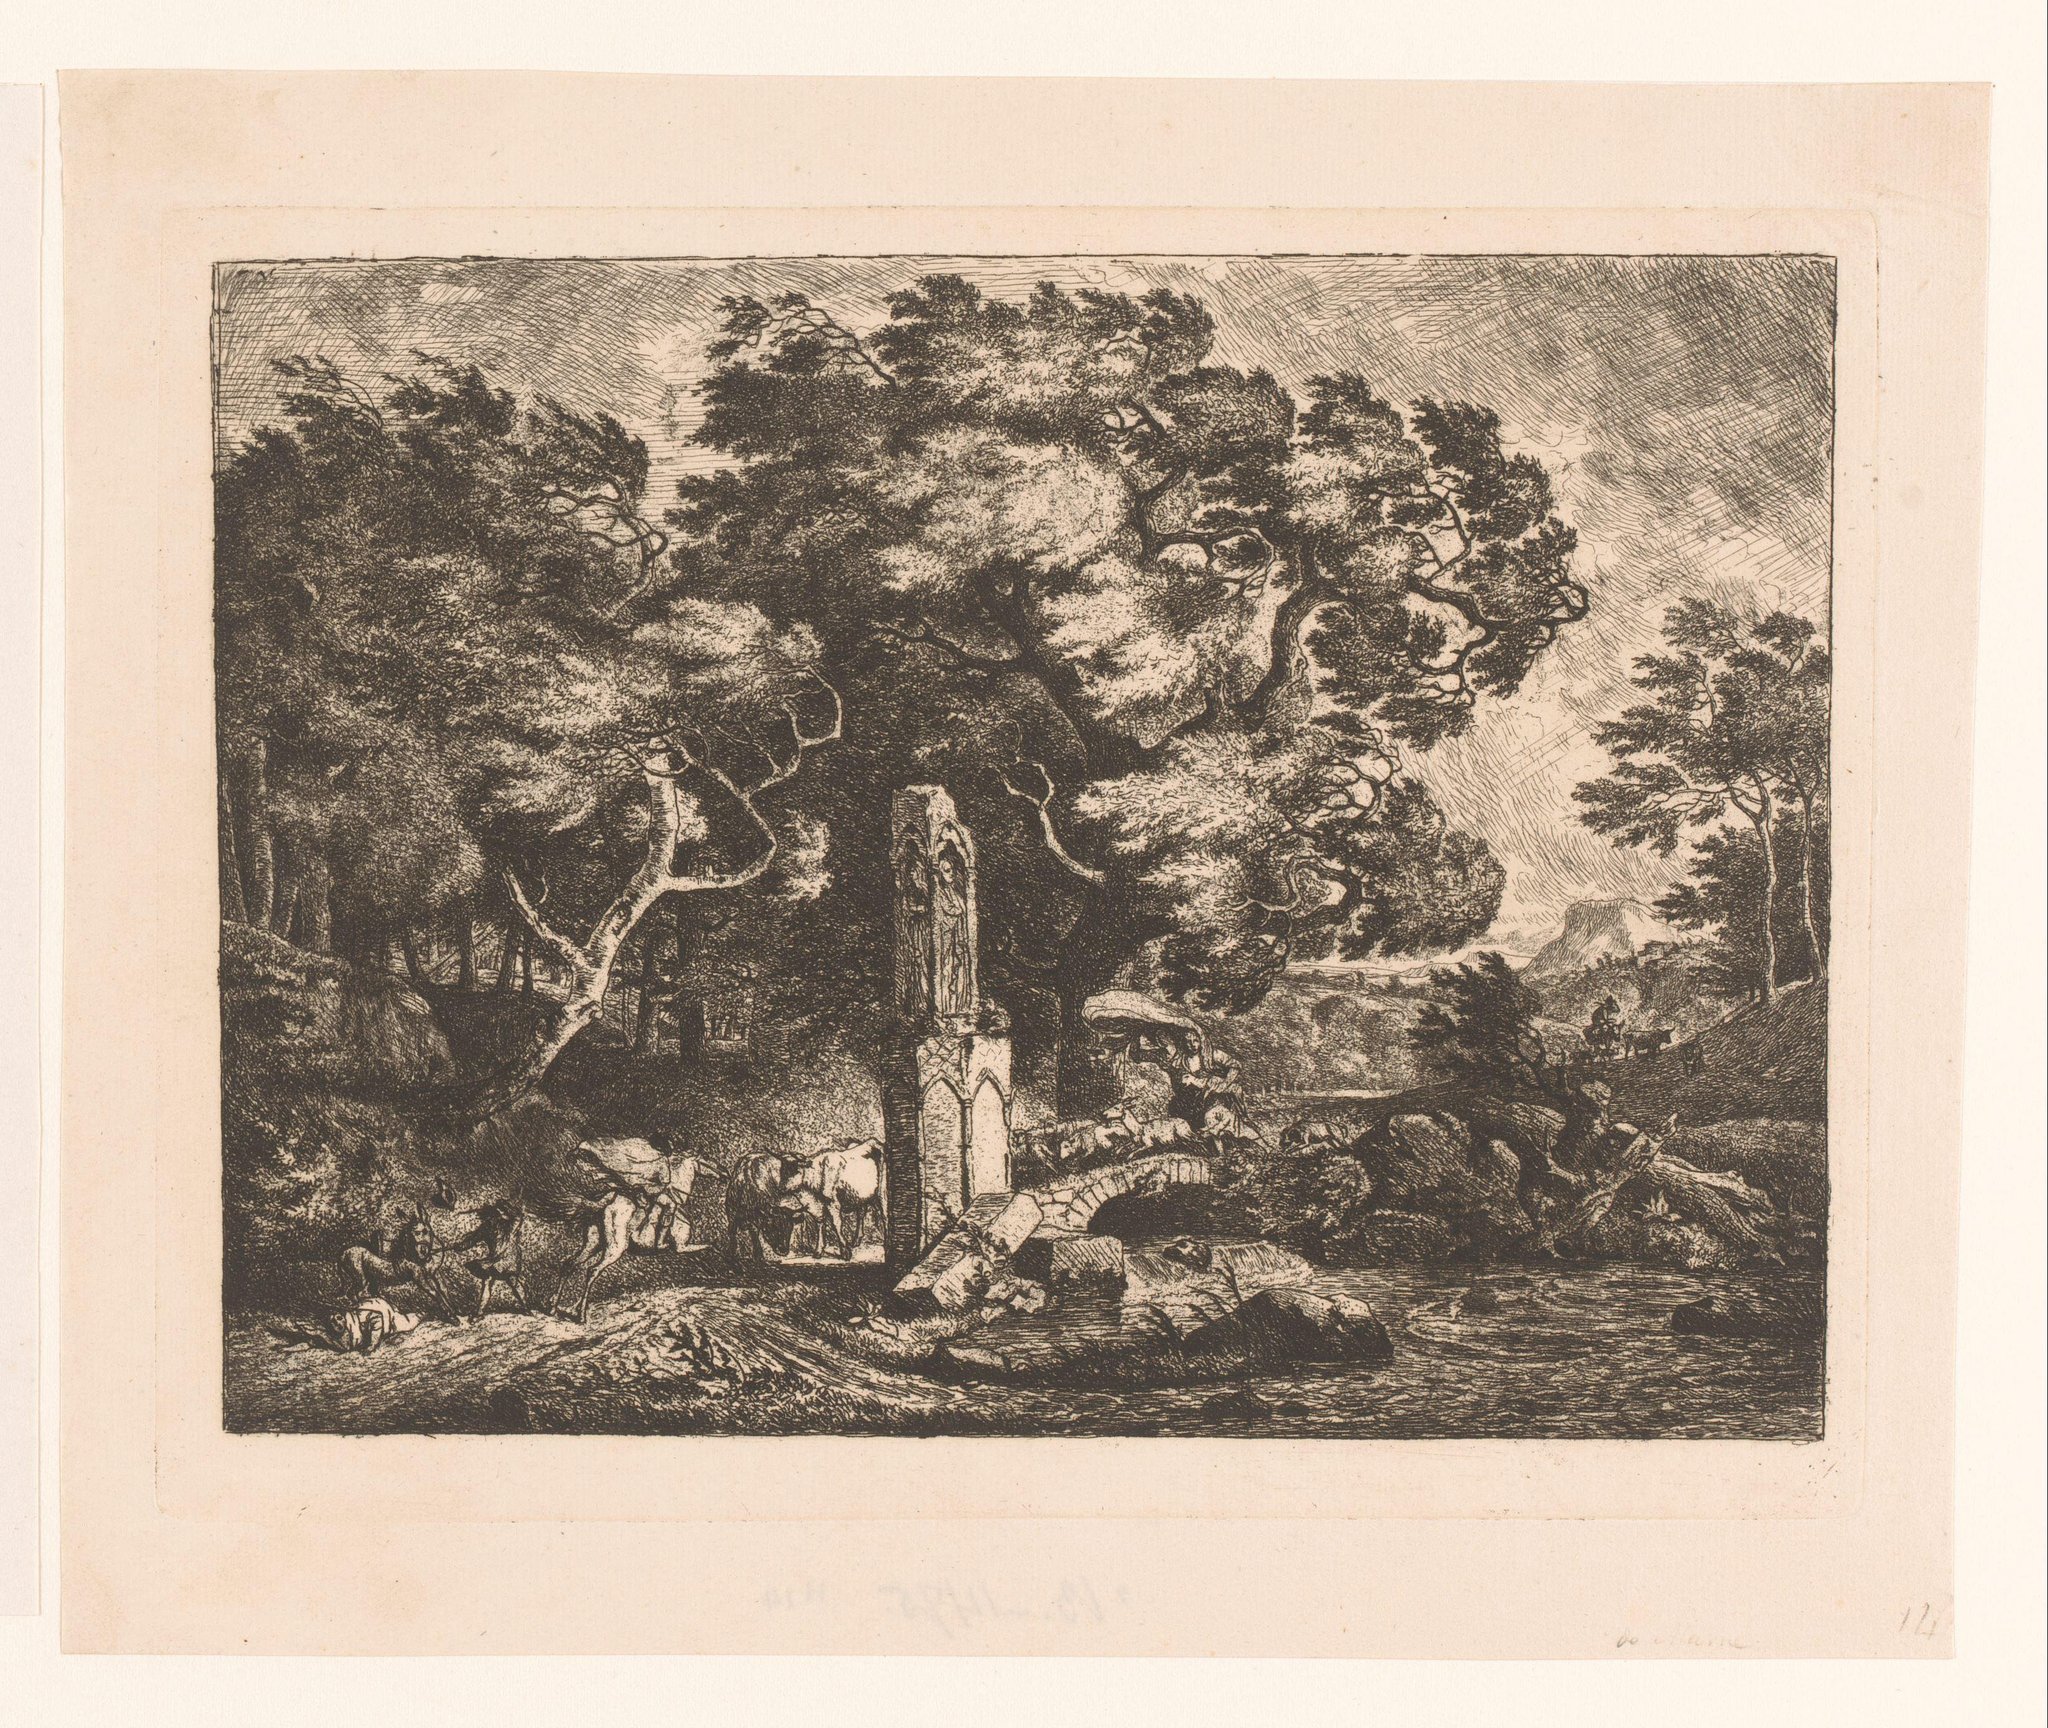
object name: print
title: Windvlaag waait langs bomen en een stenen brug met figuren en dieren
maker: jean louis demarne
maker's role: draughtsman, painter, print maker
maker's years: 1752-1829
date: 1762-1829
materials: paper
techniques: etching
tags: animals, landscapes with waters, waterscapes, seascapes (in the temperate zone), winds, bridge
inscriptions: collector's mark: Lugt 2228, collector's mark: Lugt 1485